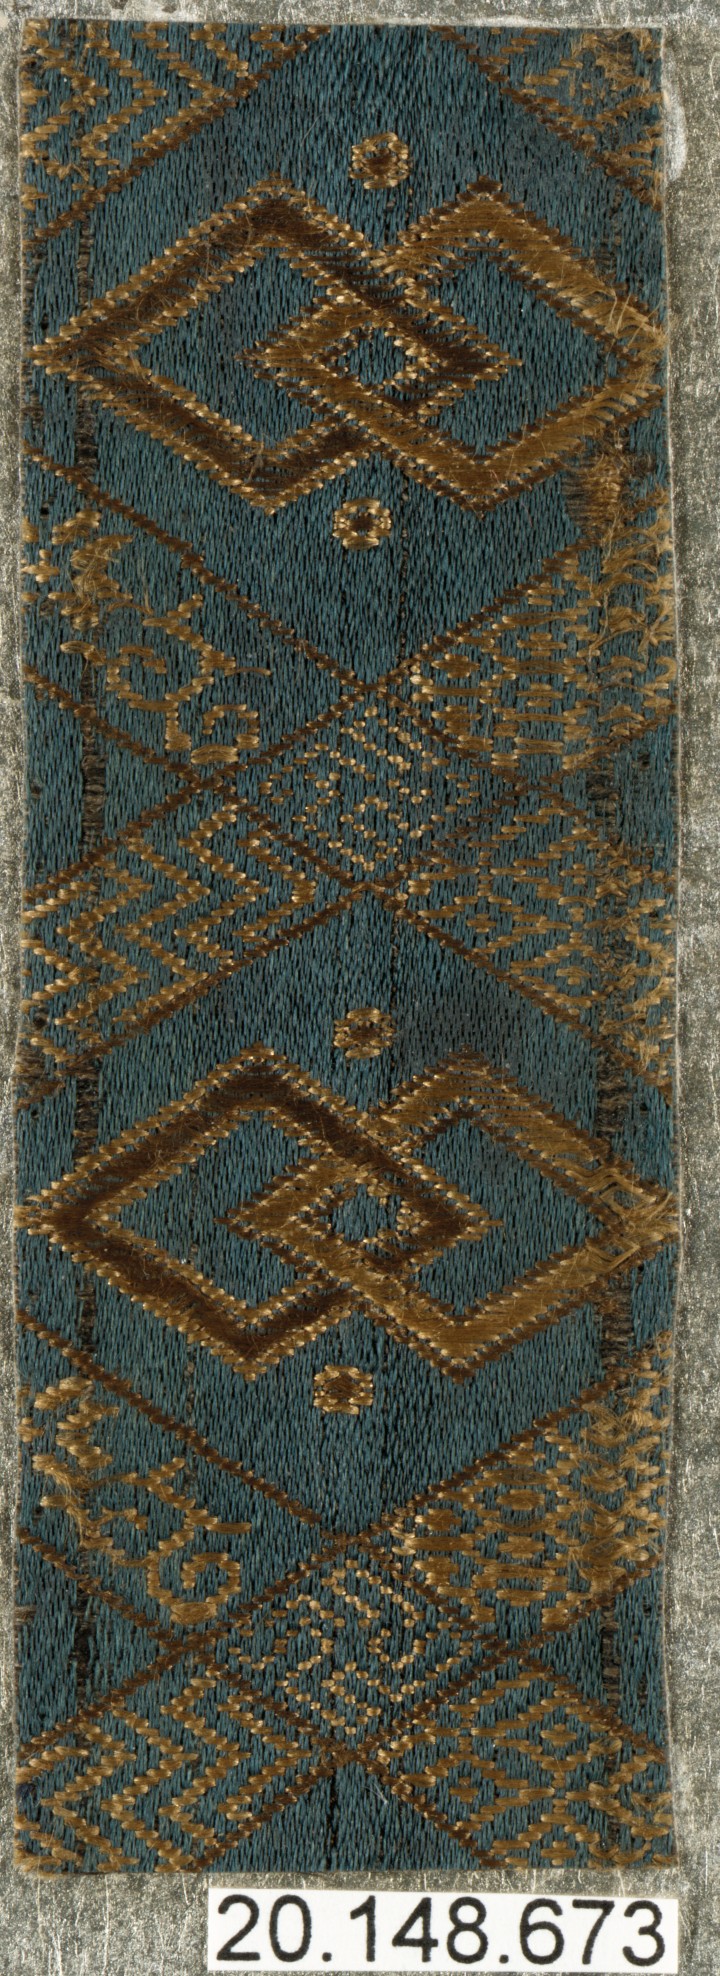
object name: piece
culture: japanese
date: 1801-1900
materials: silk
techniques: compound weave